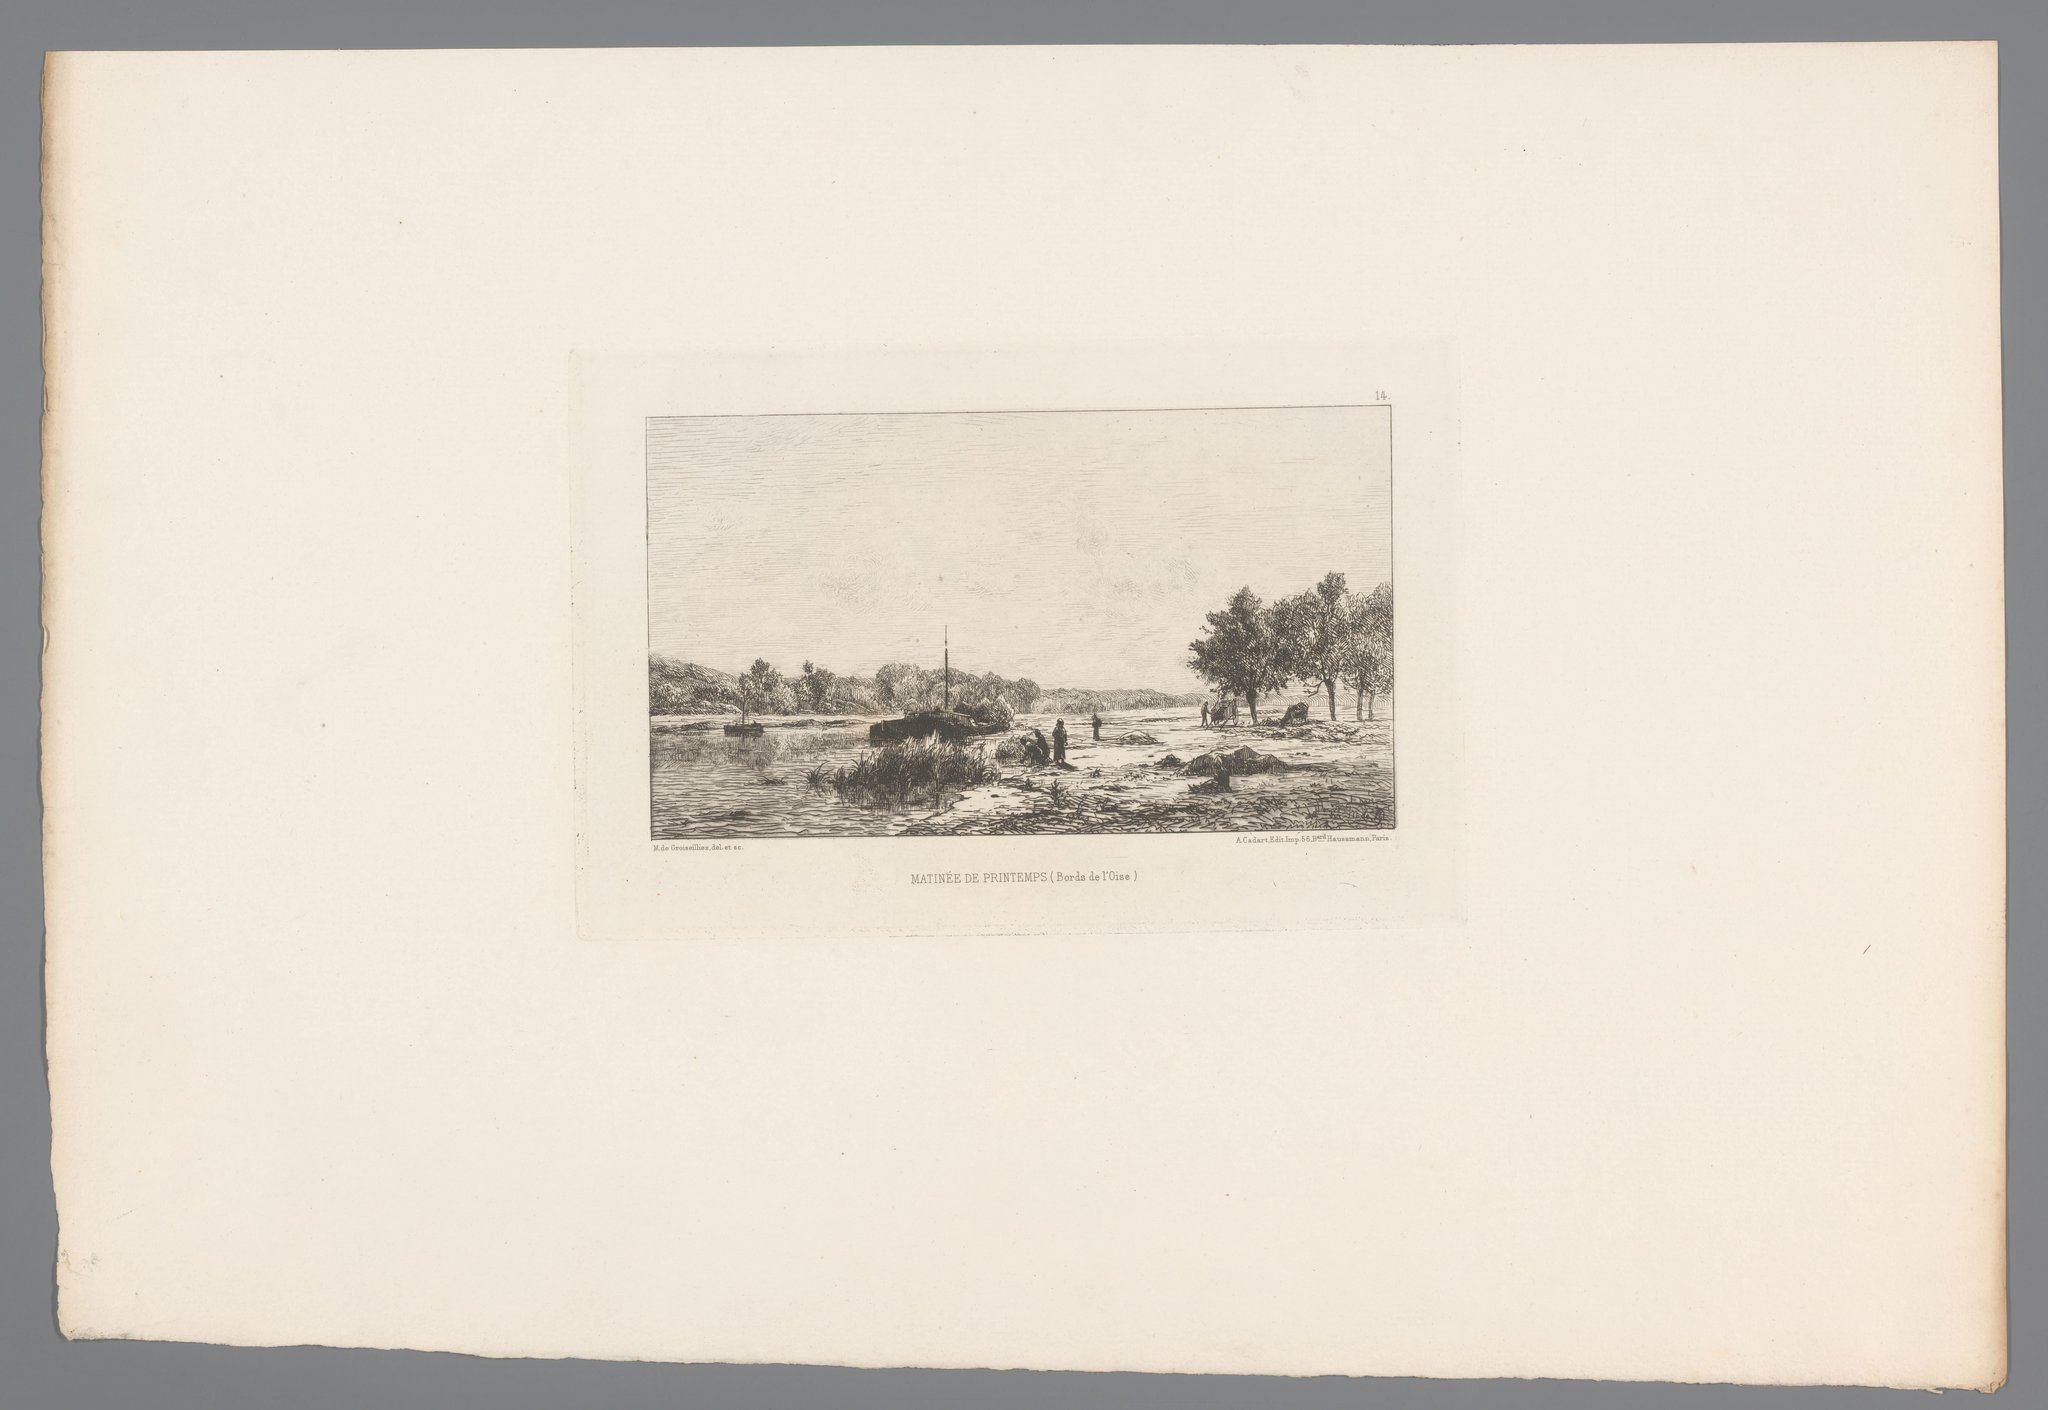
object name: print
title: Franse etsen uit 1875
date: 1875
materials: paper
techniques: drypoint, etching, intaglio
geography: paris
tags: spring, 'ver'; 'primavera' (ripa), river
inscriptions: collector's mark: Lugt 2760, collector's mark: Lugt 2228, watermark, collector's mark: ‘AFE v S’